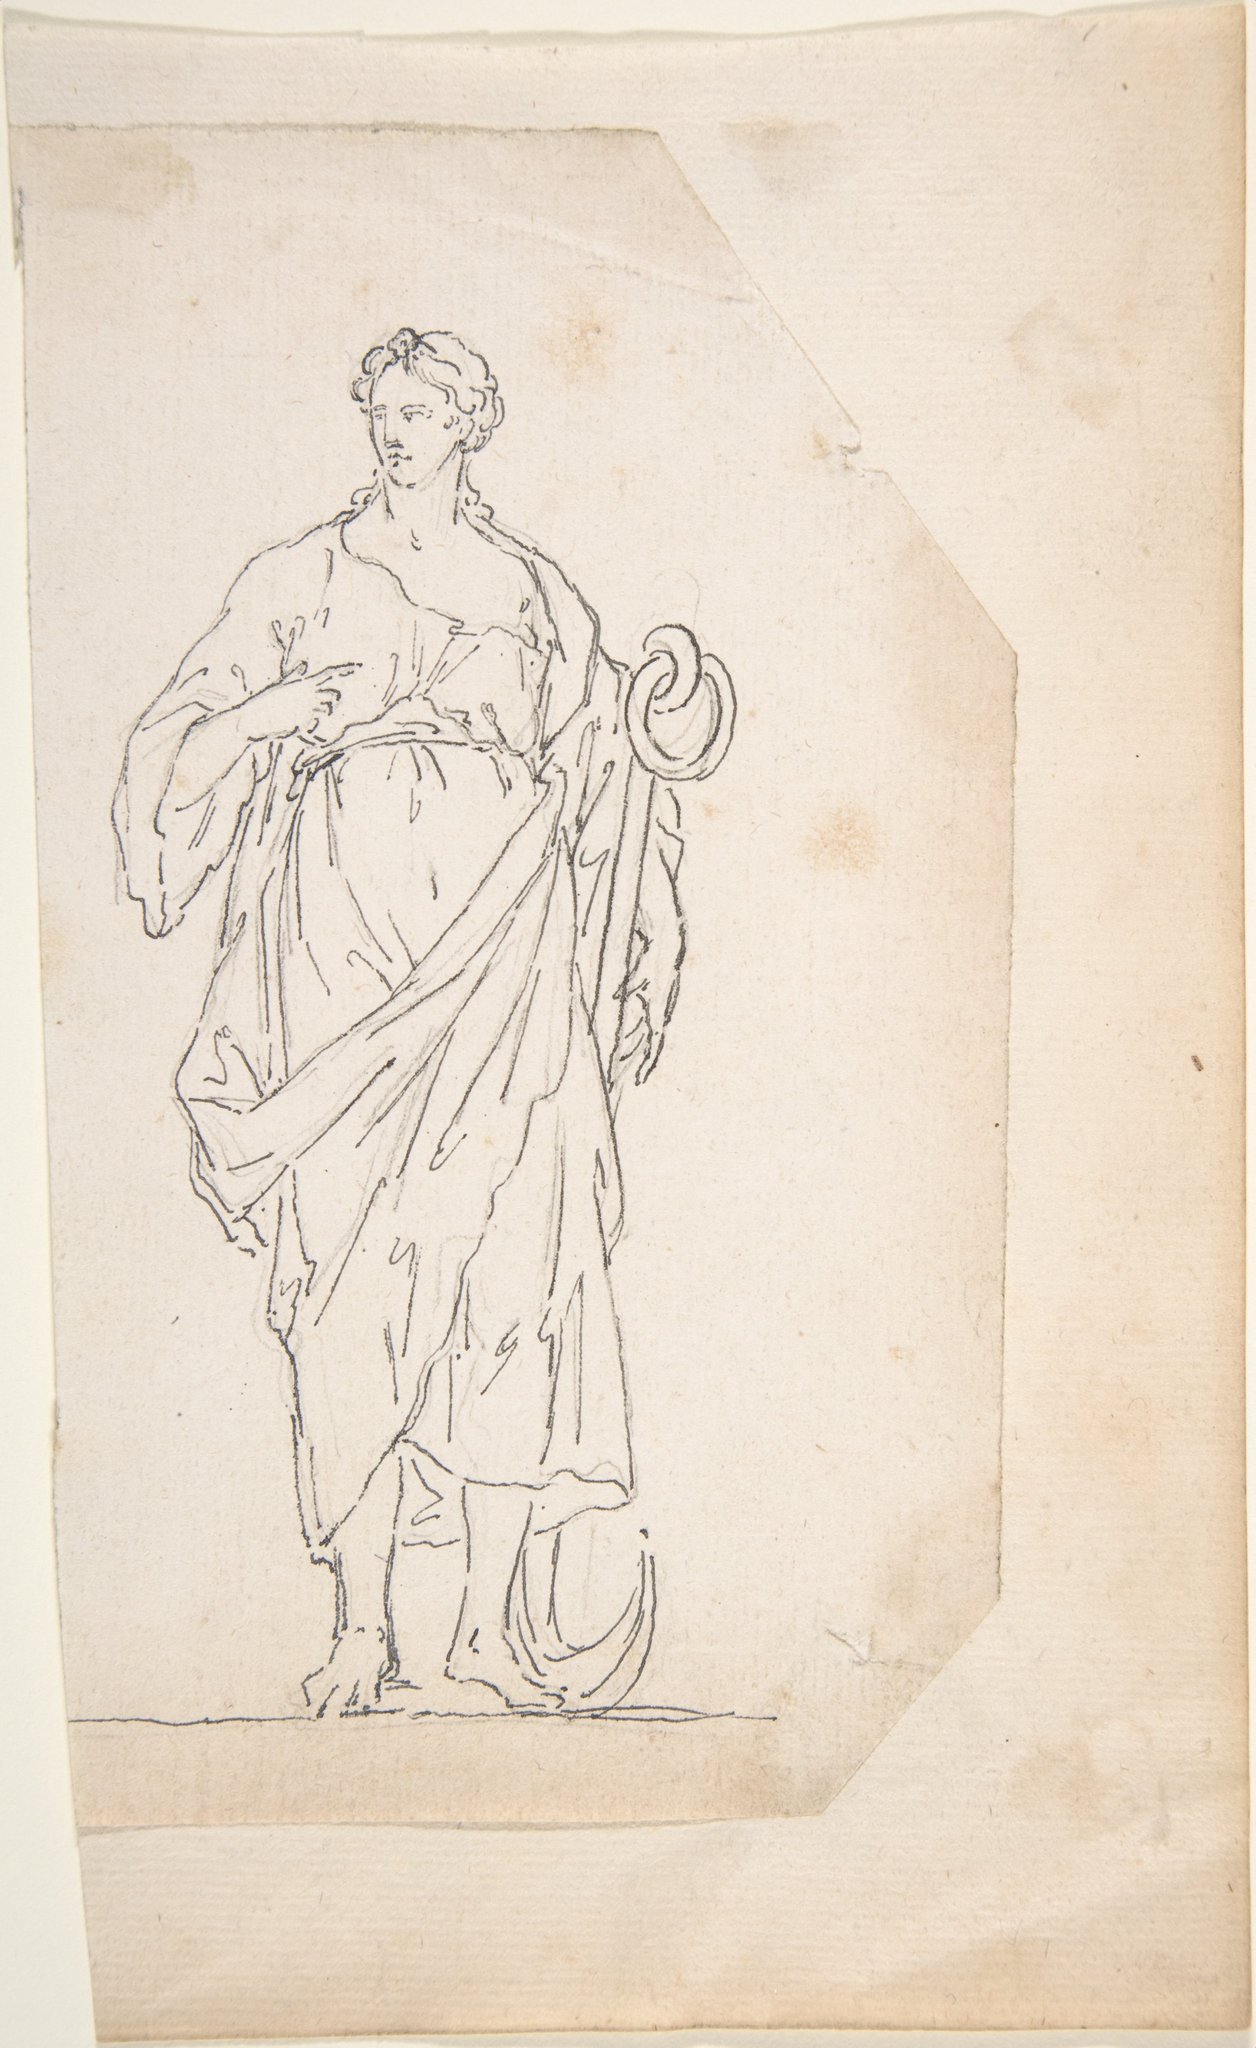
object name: drawing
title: Female Figure with Anchor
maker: anonymous, french, 18th century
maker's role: artist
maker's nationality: french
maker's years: 1700-1800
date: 1701-1800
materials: graphite, ink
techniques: pen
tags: women